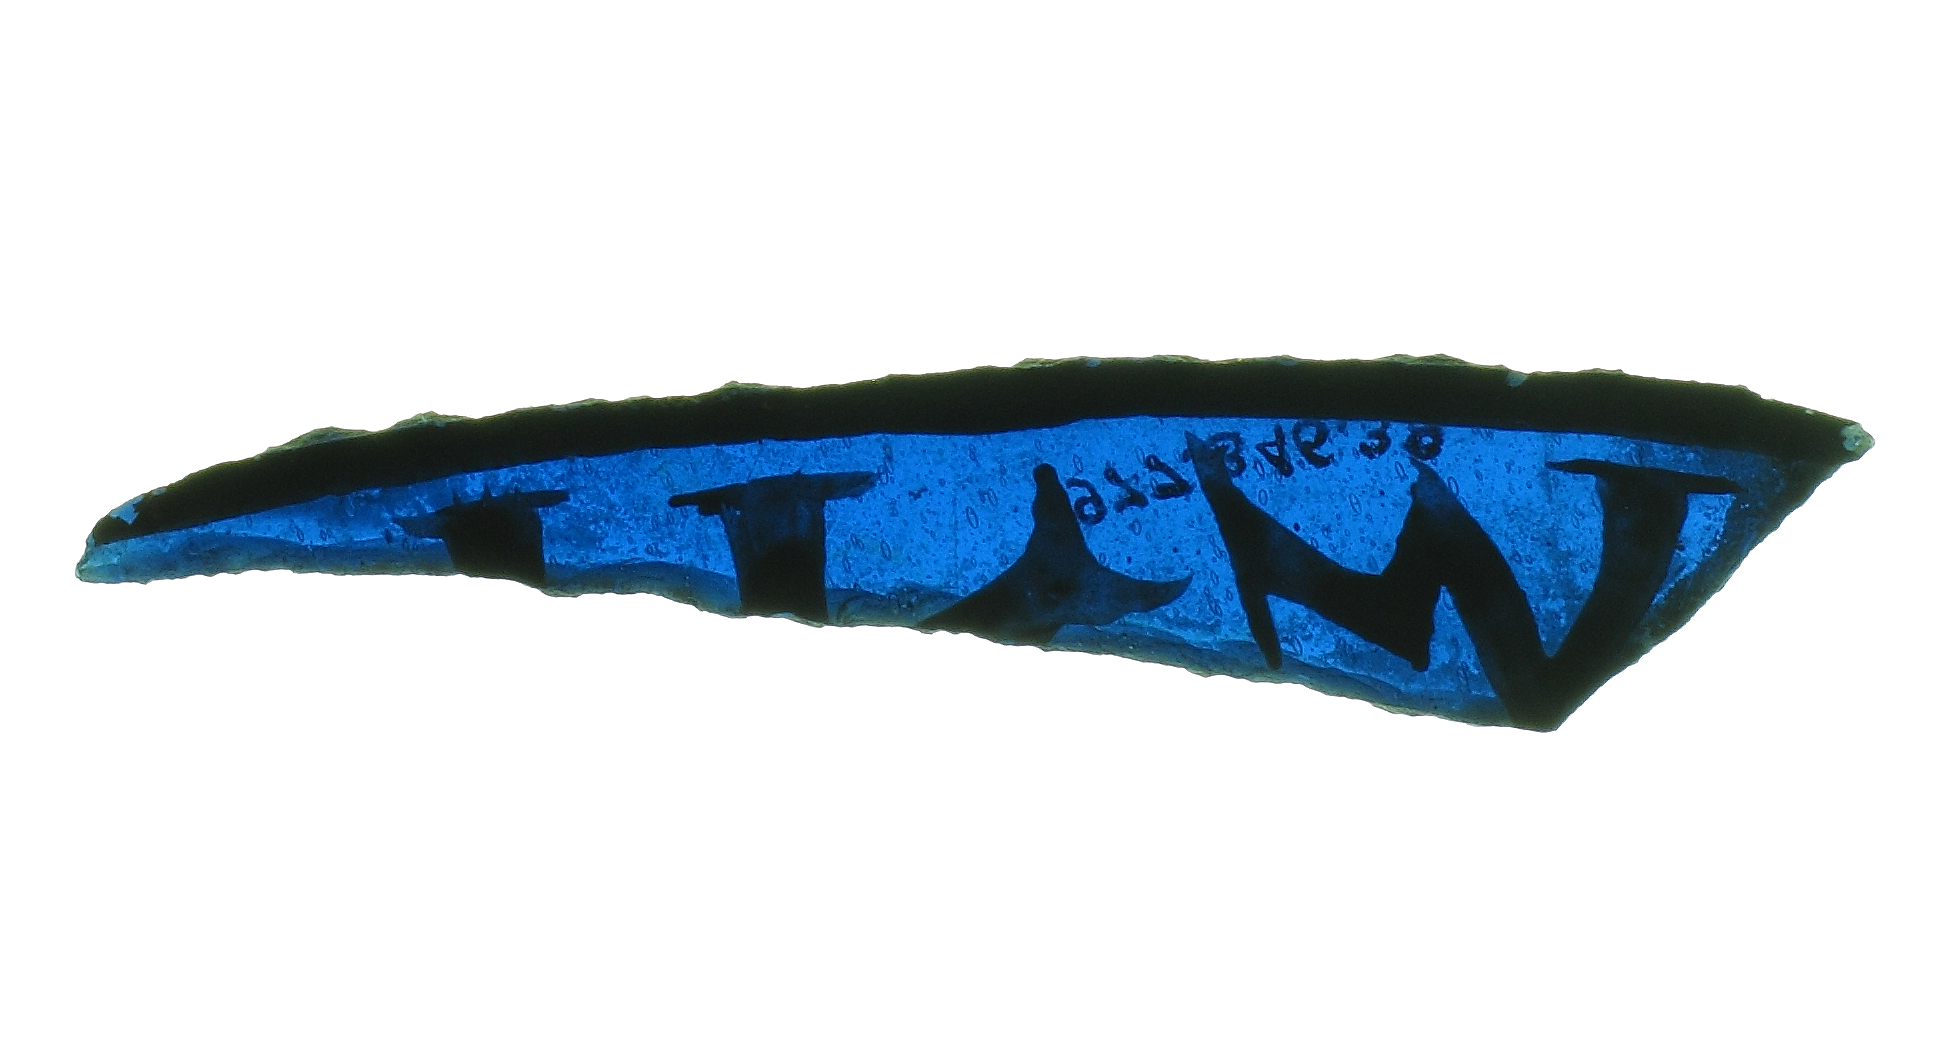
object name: fragment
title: Glass Fragment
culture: french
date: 1101-1400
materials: glass, metal, paint